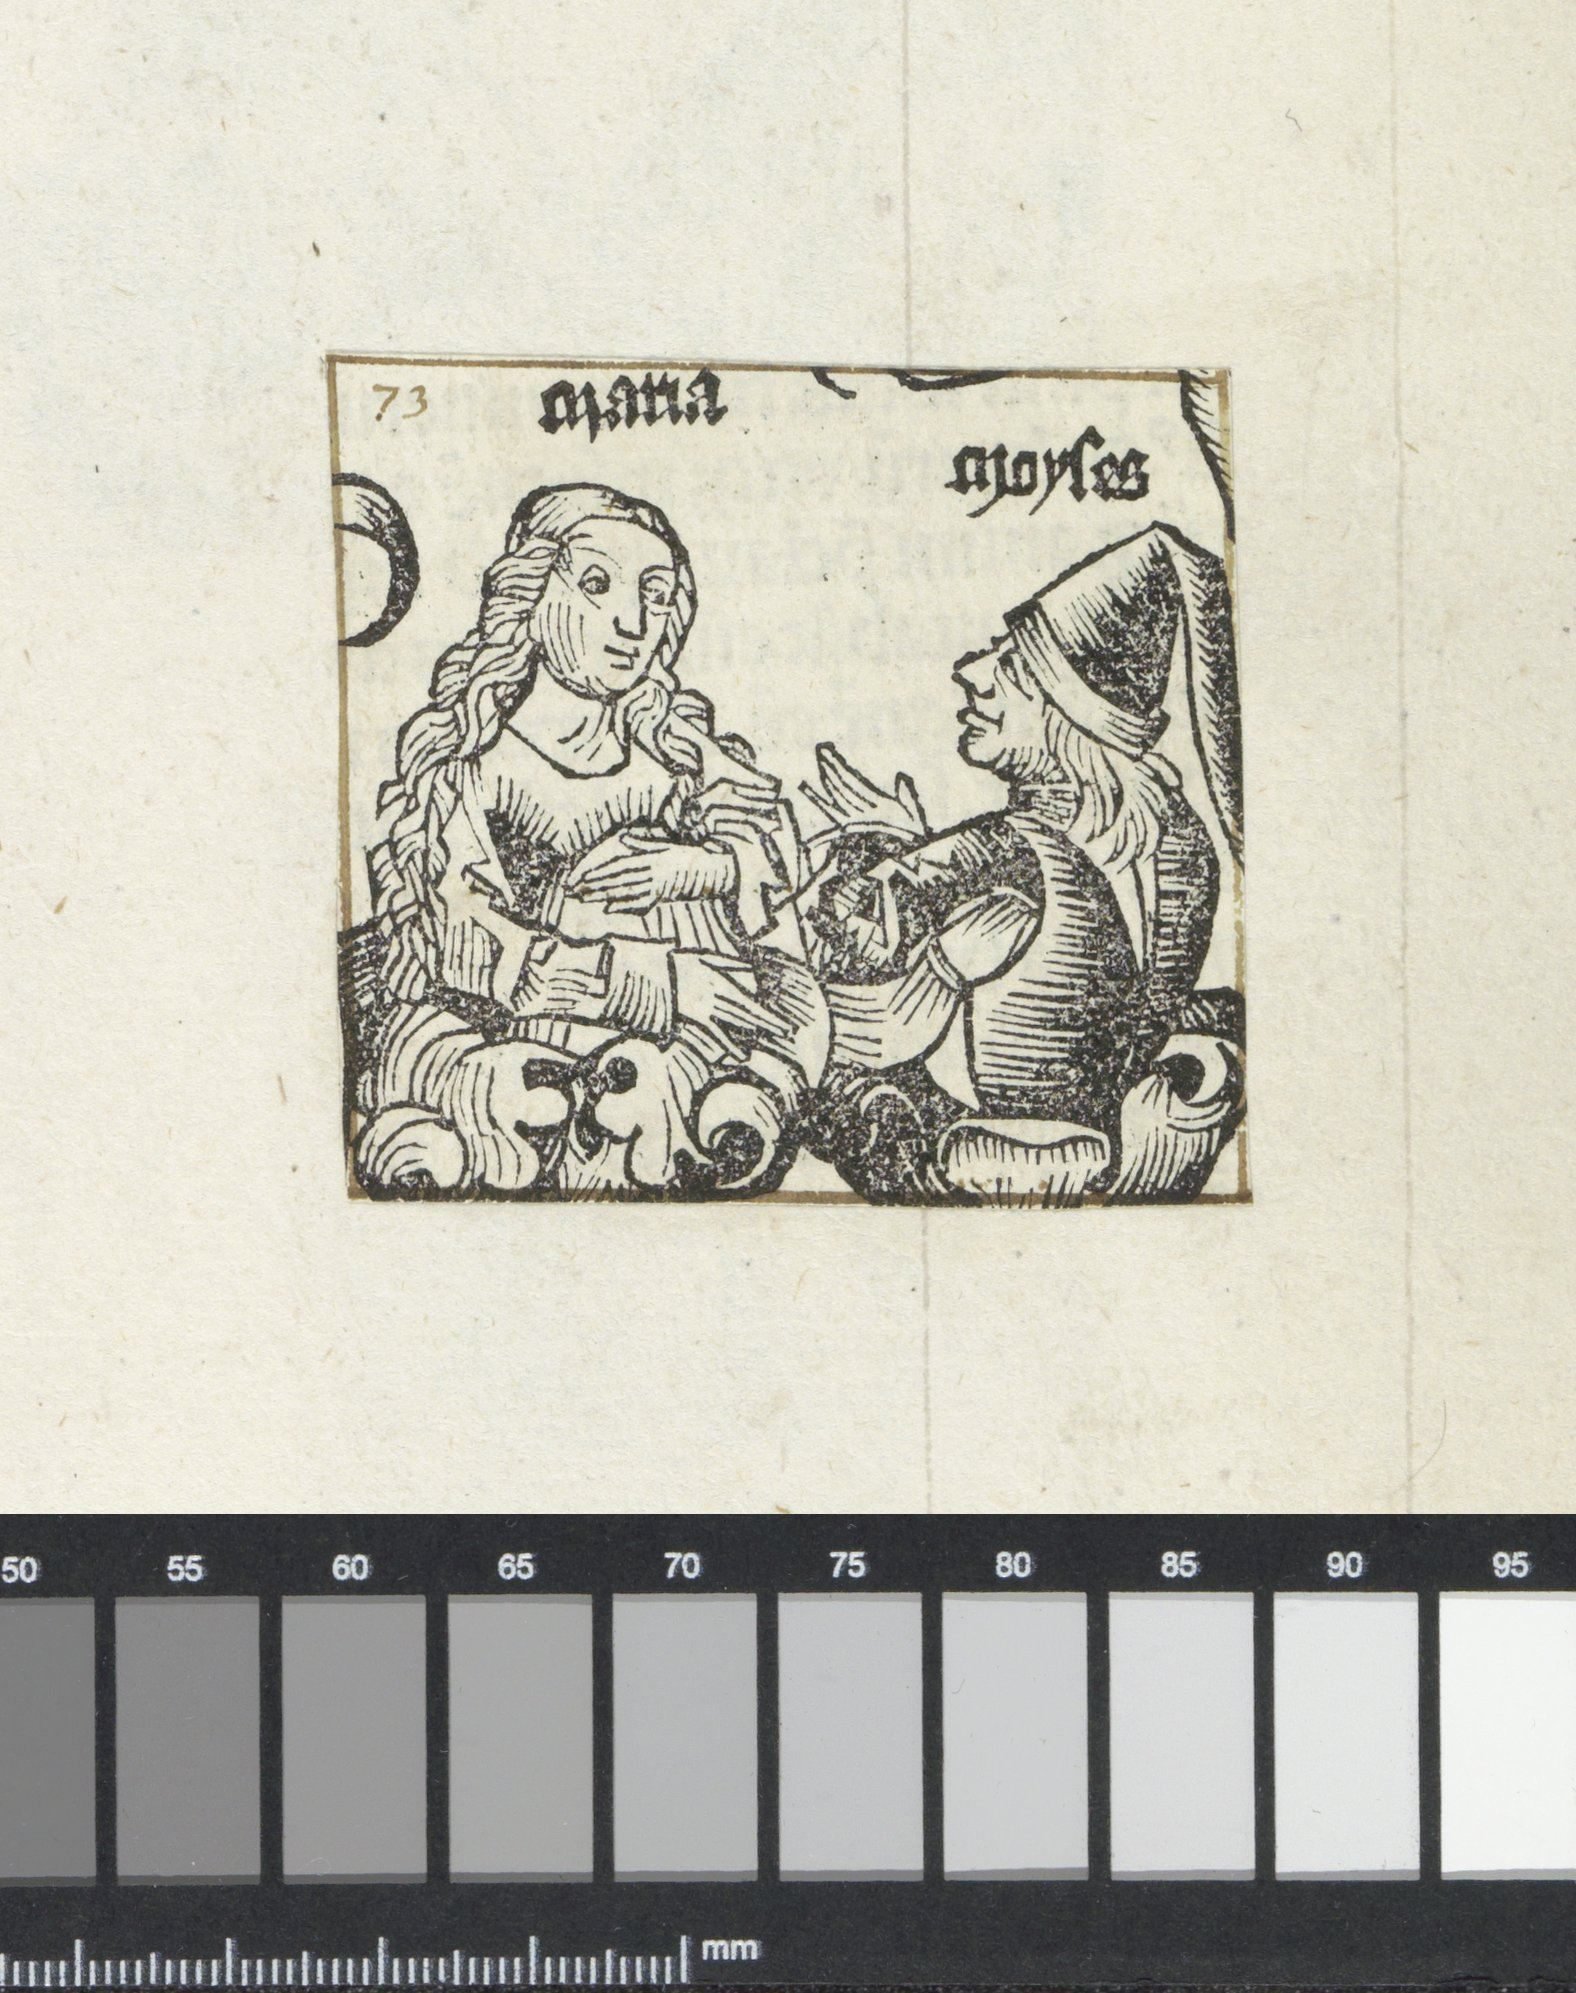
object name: album leaf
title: Mirjam en Mozes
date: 1493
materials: paper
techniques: letterpress printing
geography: nuremberg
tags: persons from the old testament (not in biblical context, nor occurring in legendary/historical extensions included in division 71)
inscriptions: inscription: ‘73’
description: Twee bloemkelken met een man en een vrouw. De vrouw heeft het haar los. De man draagt een puntmuts. De voorstelling is een fragment van de stamboom van Christus in de Liber Chronicarum. De tekst identificeert de personen als kinderen van Amram, genaamd Mirjam (hier Maria) en Mozes. De prent maakt deel uit van een album.